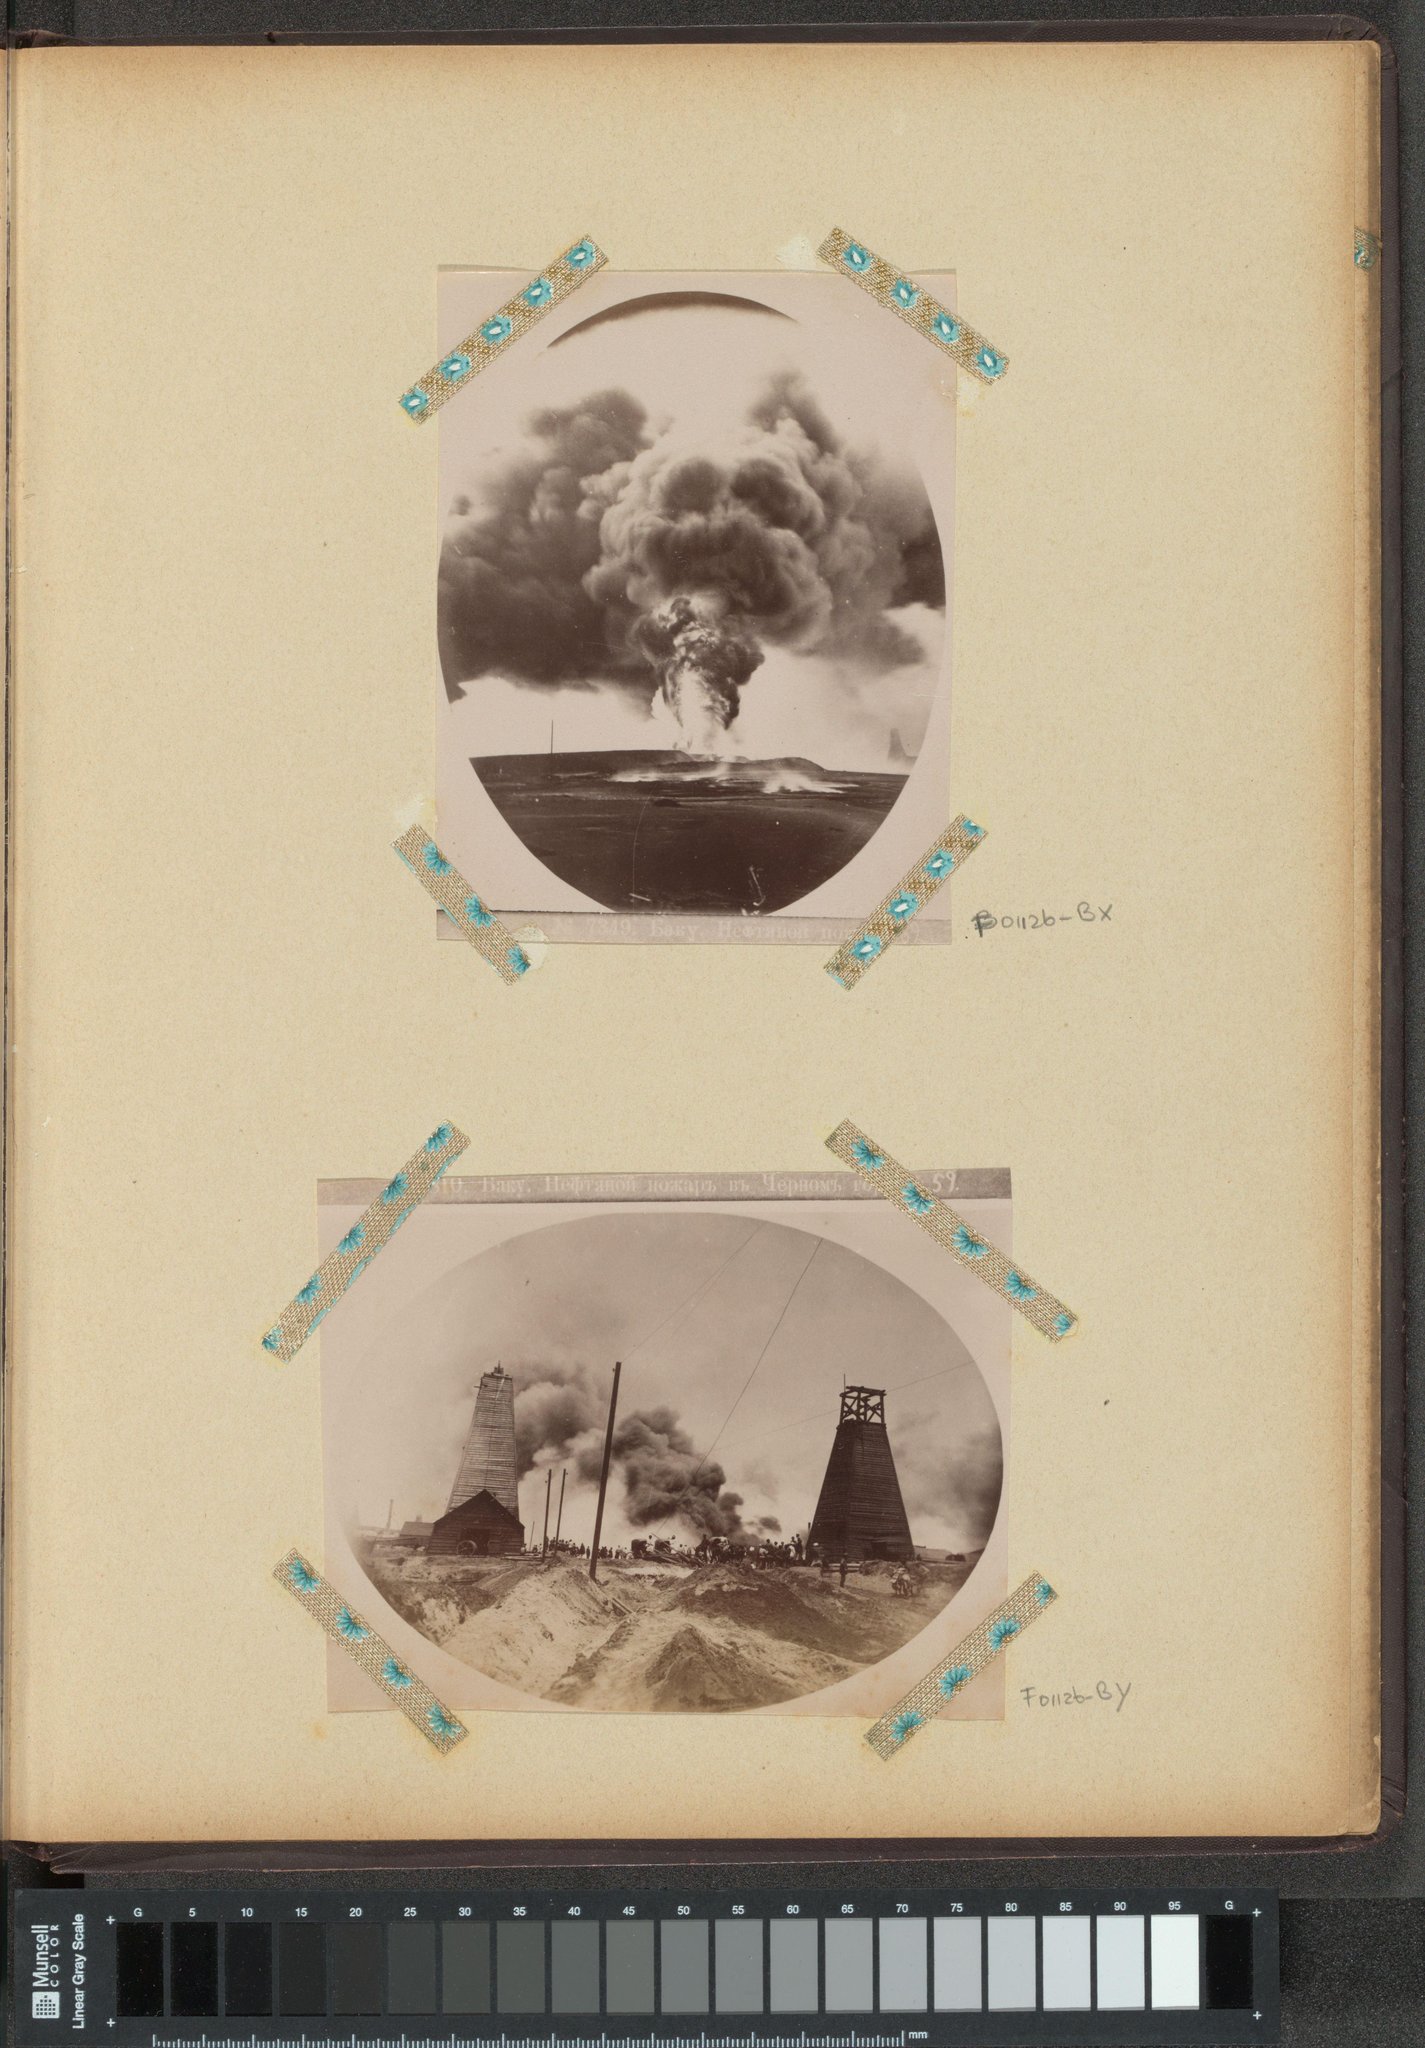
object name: photograph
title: Brandende oliebron tussen twee boortorens in Bakoe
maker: Anonymous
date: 1890-1900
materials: photographic support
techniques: albumen print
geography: baku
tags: smoke, derrick ~ oil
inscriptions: number: ‘6810’, number: ‘59’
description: Onderdeel van Fotoalbum met opnames van bezienswaardigheden in Georgië, Sint-Petersburg en Moskou.